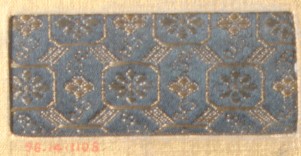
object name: piece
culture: japanese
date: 1701-1900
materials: silk